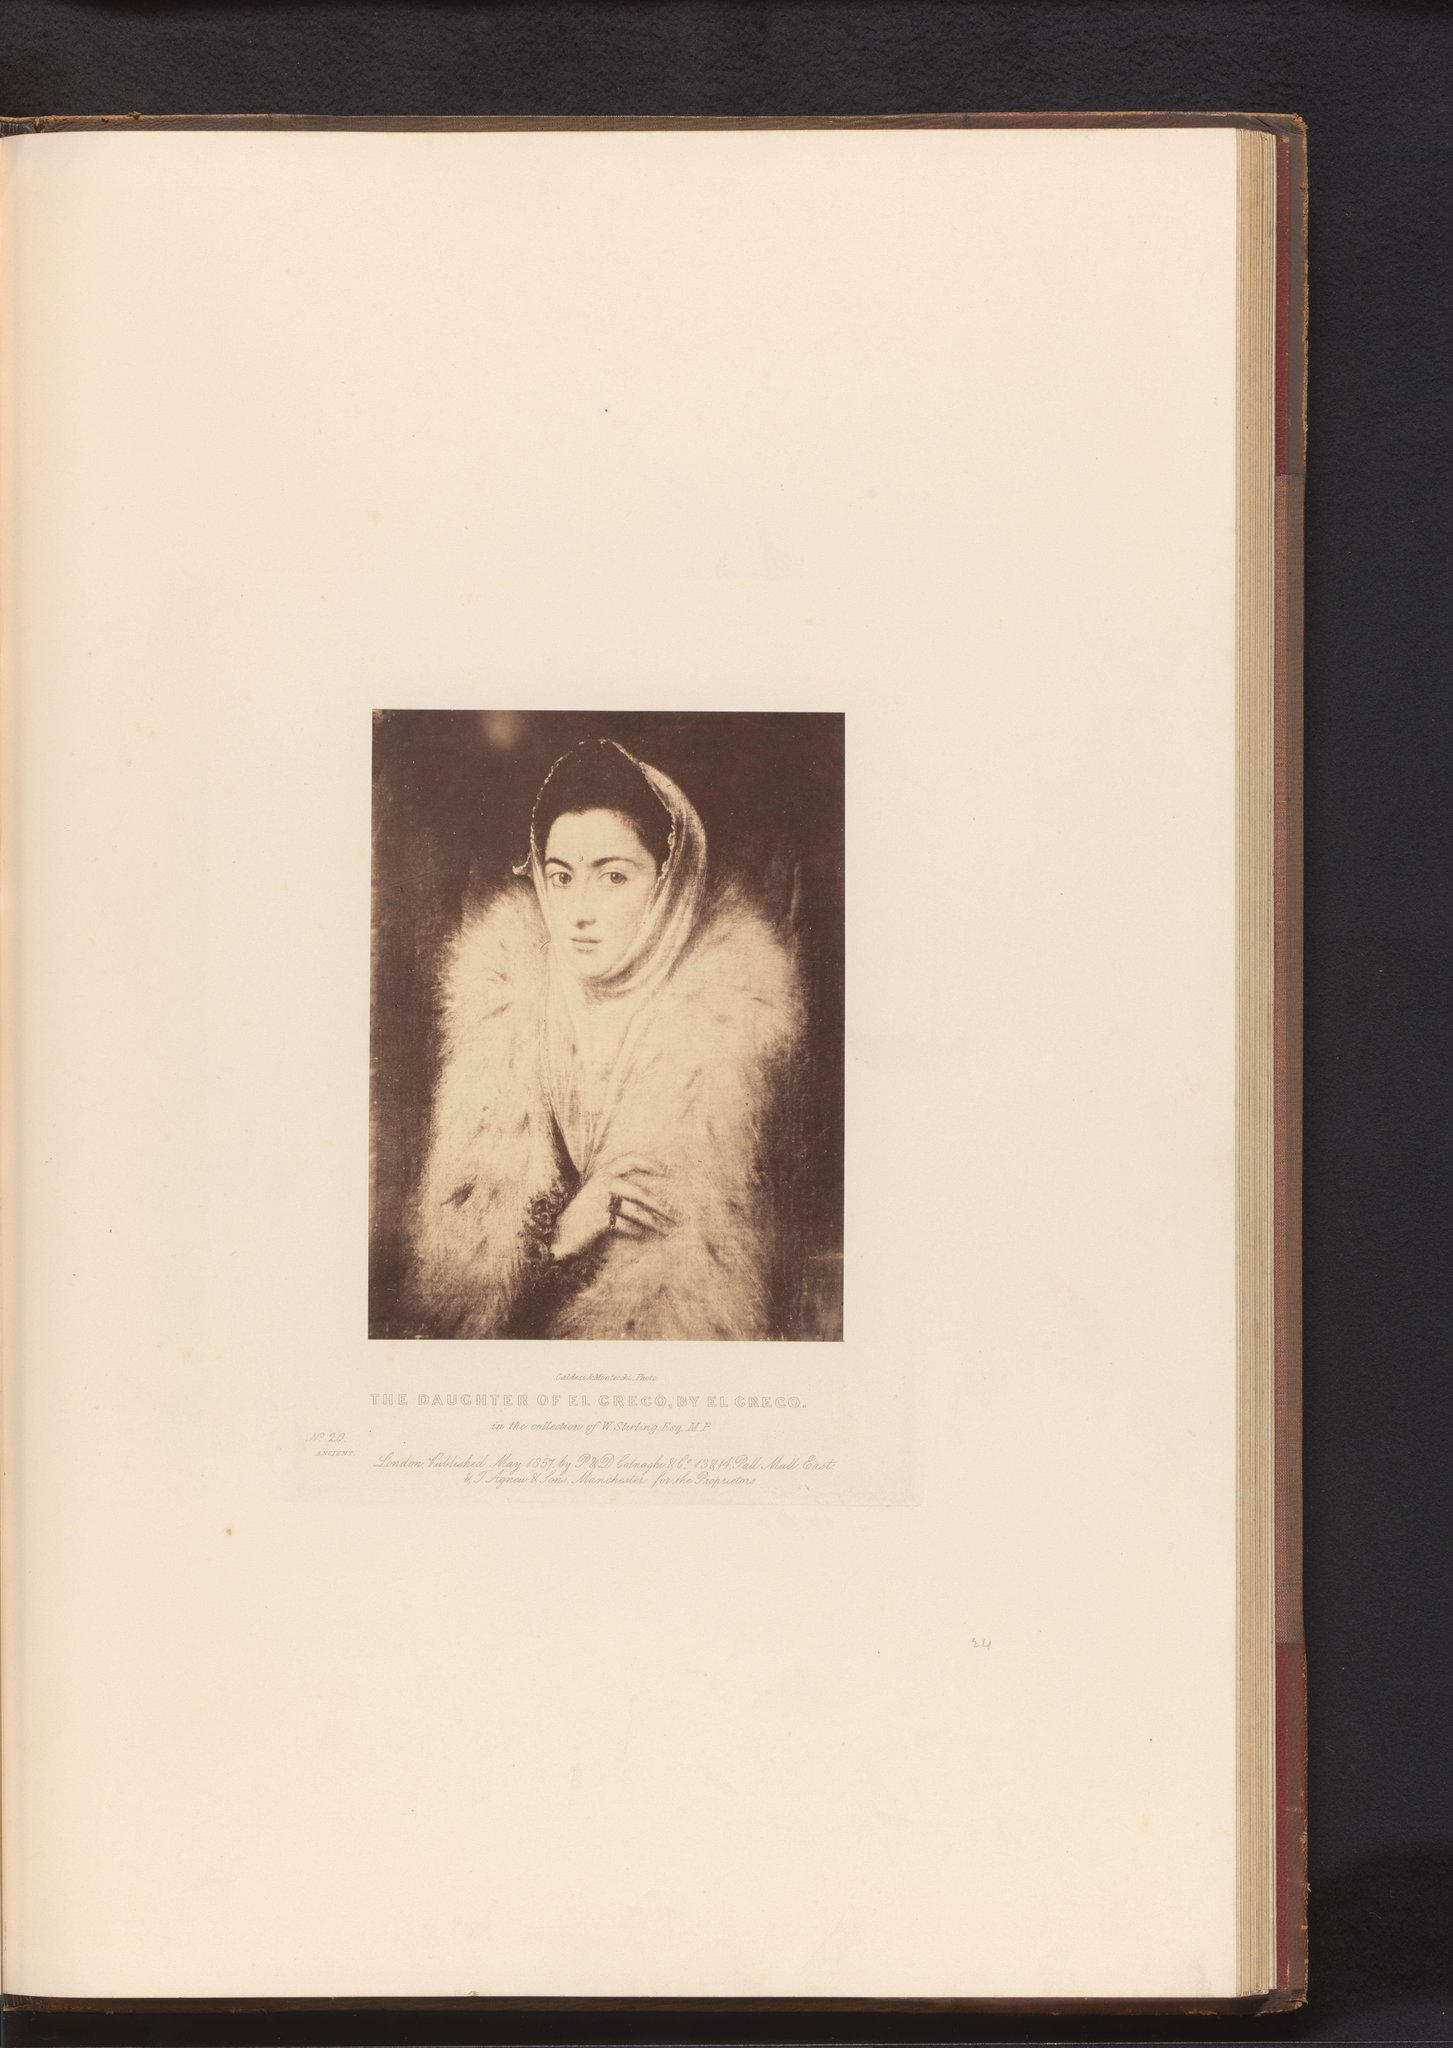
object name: page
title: Fotoreproductie van een schilderij van een portret van een onbekende vrouw in bont gekleed, door El Greco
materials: photographic support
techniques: albumen print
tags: historical persons not known by name - bb - woman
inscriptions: number: ‘No. 20./ MODERN.’, number: ‘24’, inscription: ‘In the Collection of W. Stirling, Esq, M.P./ London, Published May, 1857, by P. & D. Colnaghi & Co, 13 & 14, Pall Mall East/ & T. Agneur & Sons, Manchester. For the Proprietors.’